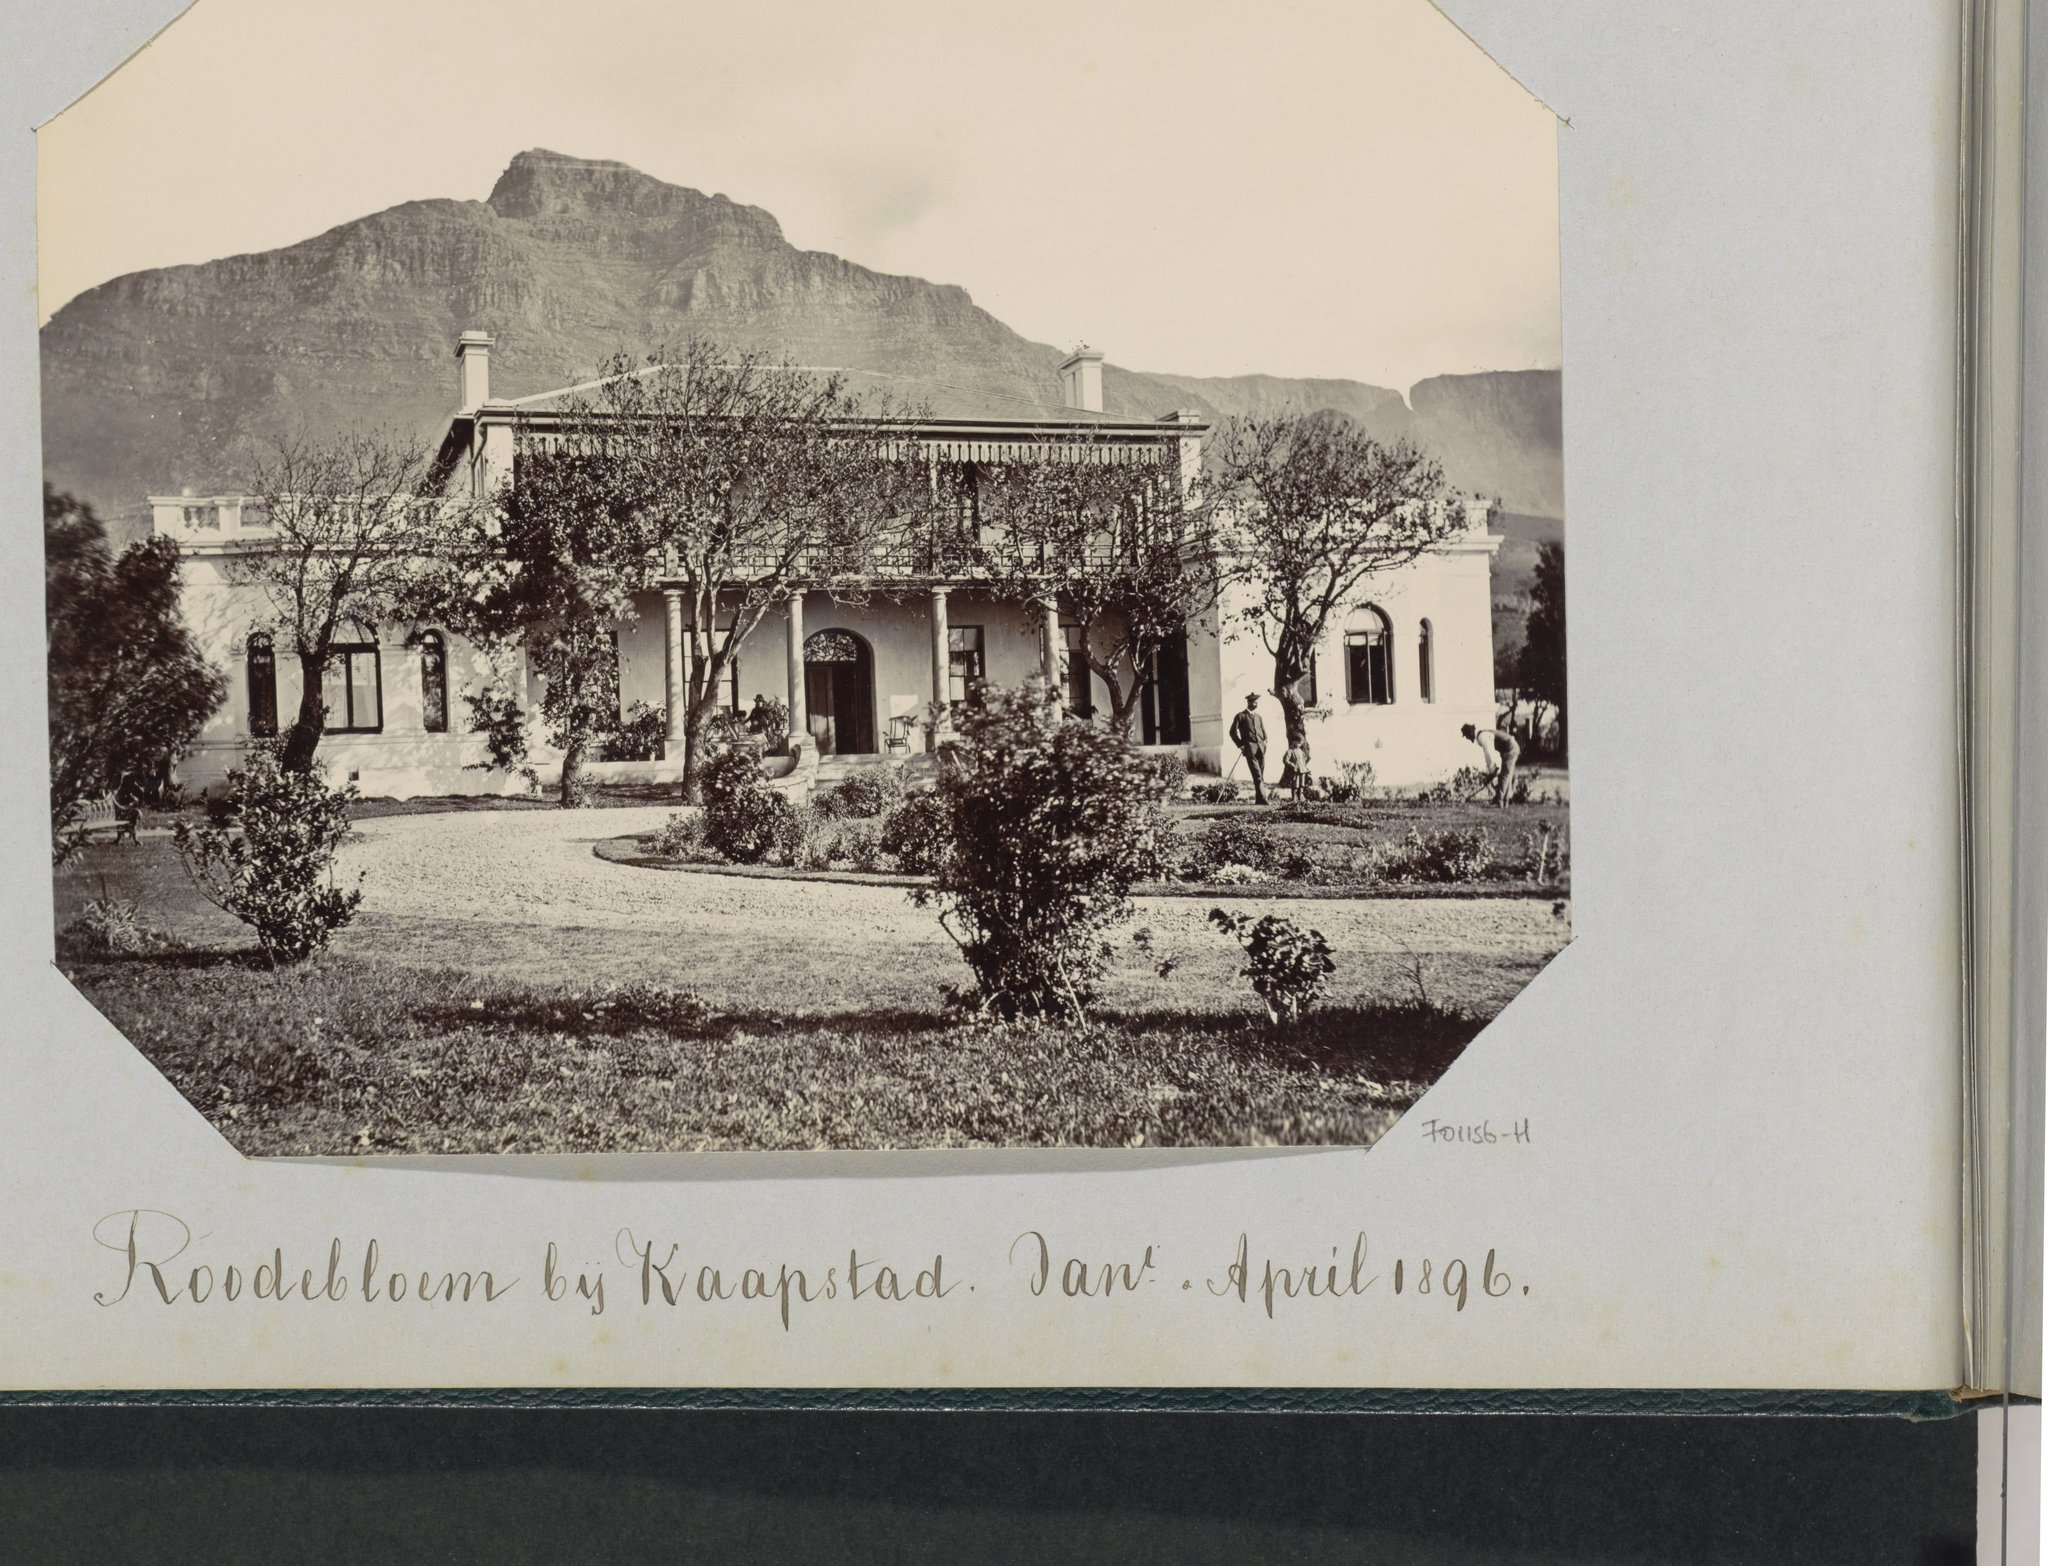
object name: photograph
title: Gezicht op huis Roodebloem te Kaapstad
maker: Anonymous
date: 1896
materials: photographic support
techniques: gelatin silver print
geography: cape town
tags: rural housing, e.g. country-house, villa, cottage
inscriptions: annotation: ‘Roodebloem bij Kaapstad Jan - April 1896’